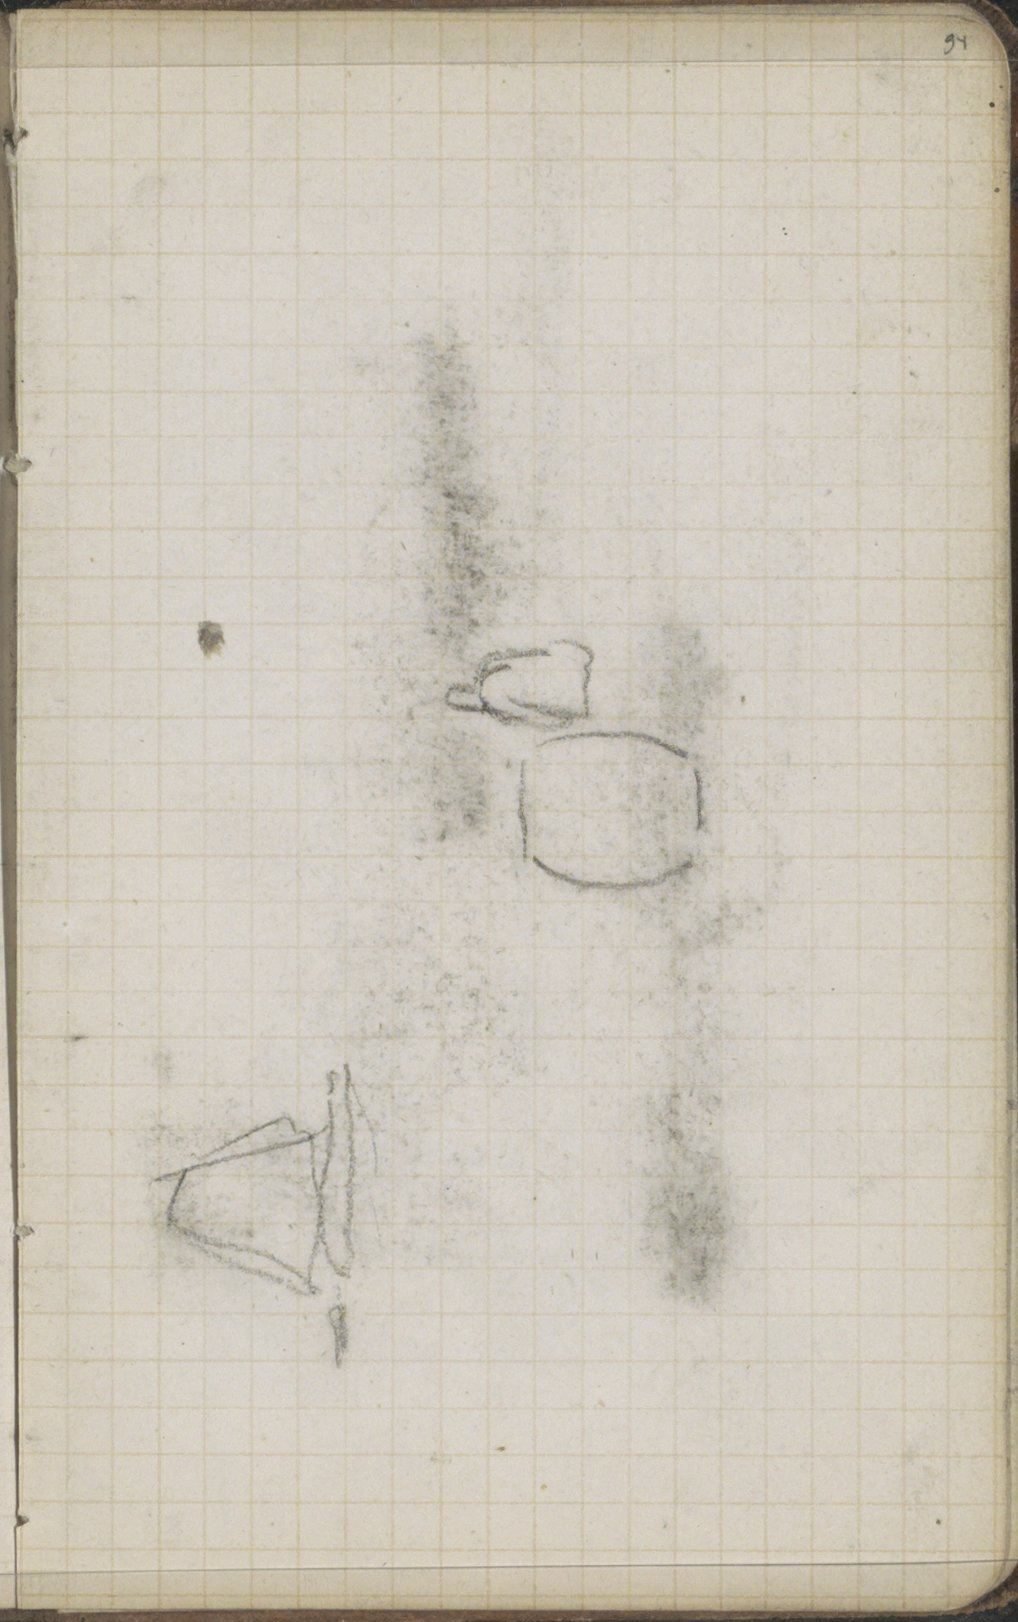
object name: sketchbook leaf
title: Zeilschip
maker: marius bauer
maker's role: draughtsman, print maker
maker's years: 1867-1932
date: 1879-1885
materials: chalk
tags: sailing-ship, sailing-boat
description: Tevens een figuurstudie. Pagina 94 uit een schetsboek met 58 bladen.